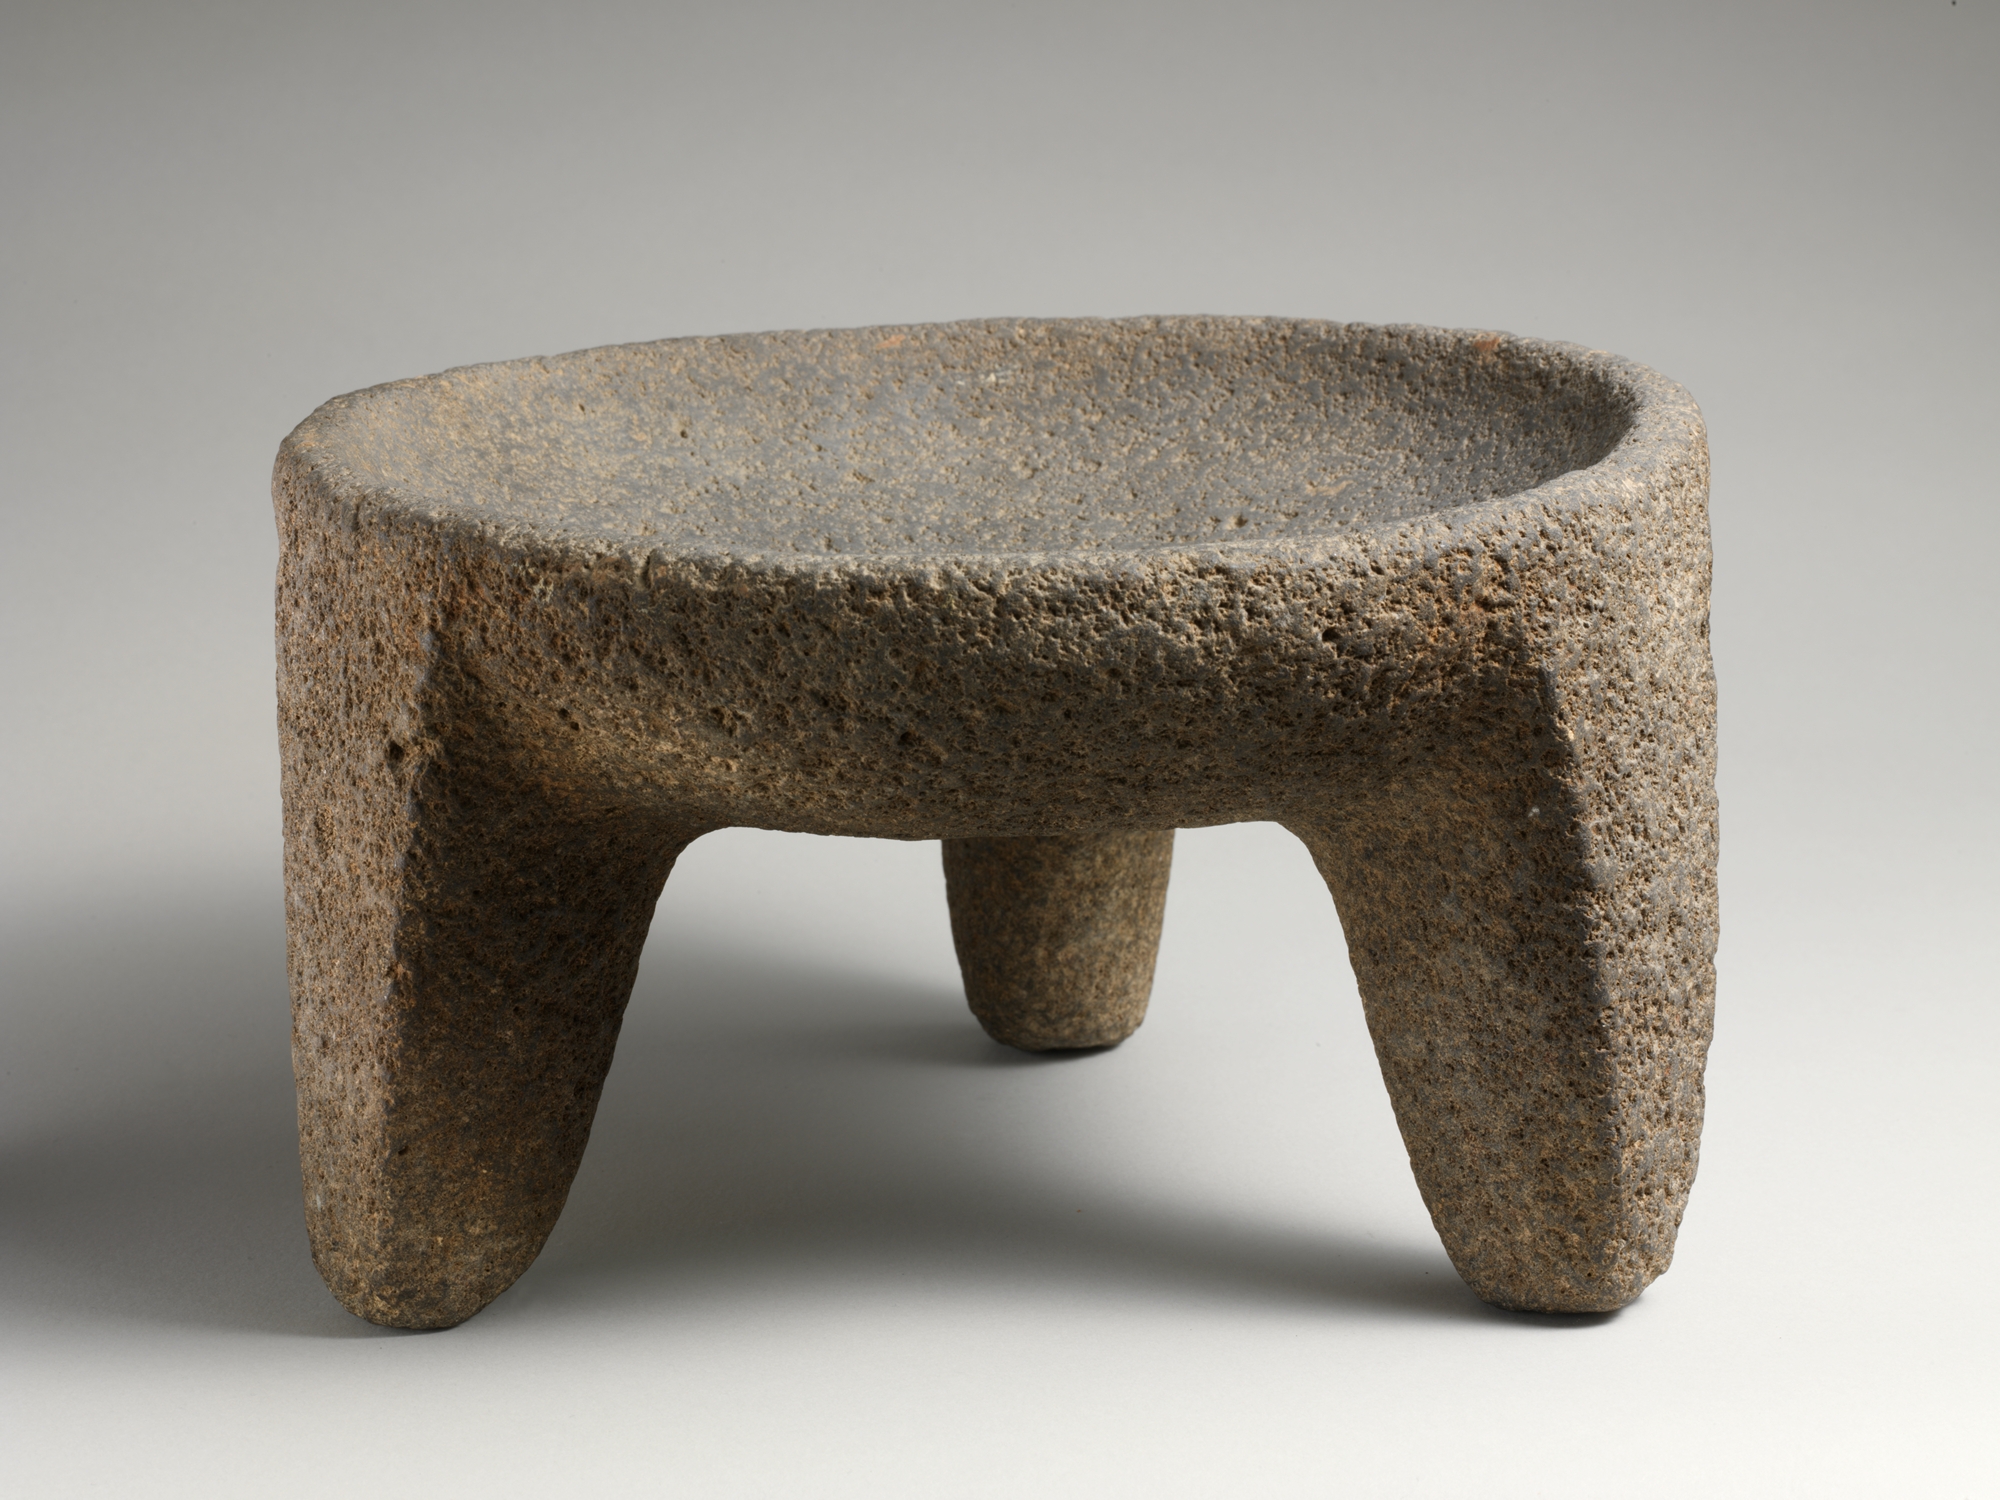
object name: mortar, three legged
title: Basalt mortar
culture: cypriot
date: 1600-700 BCE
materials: stone